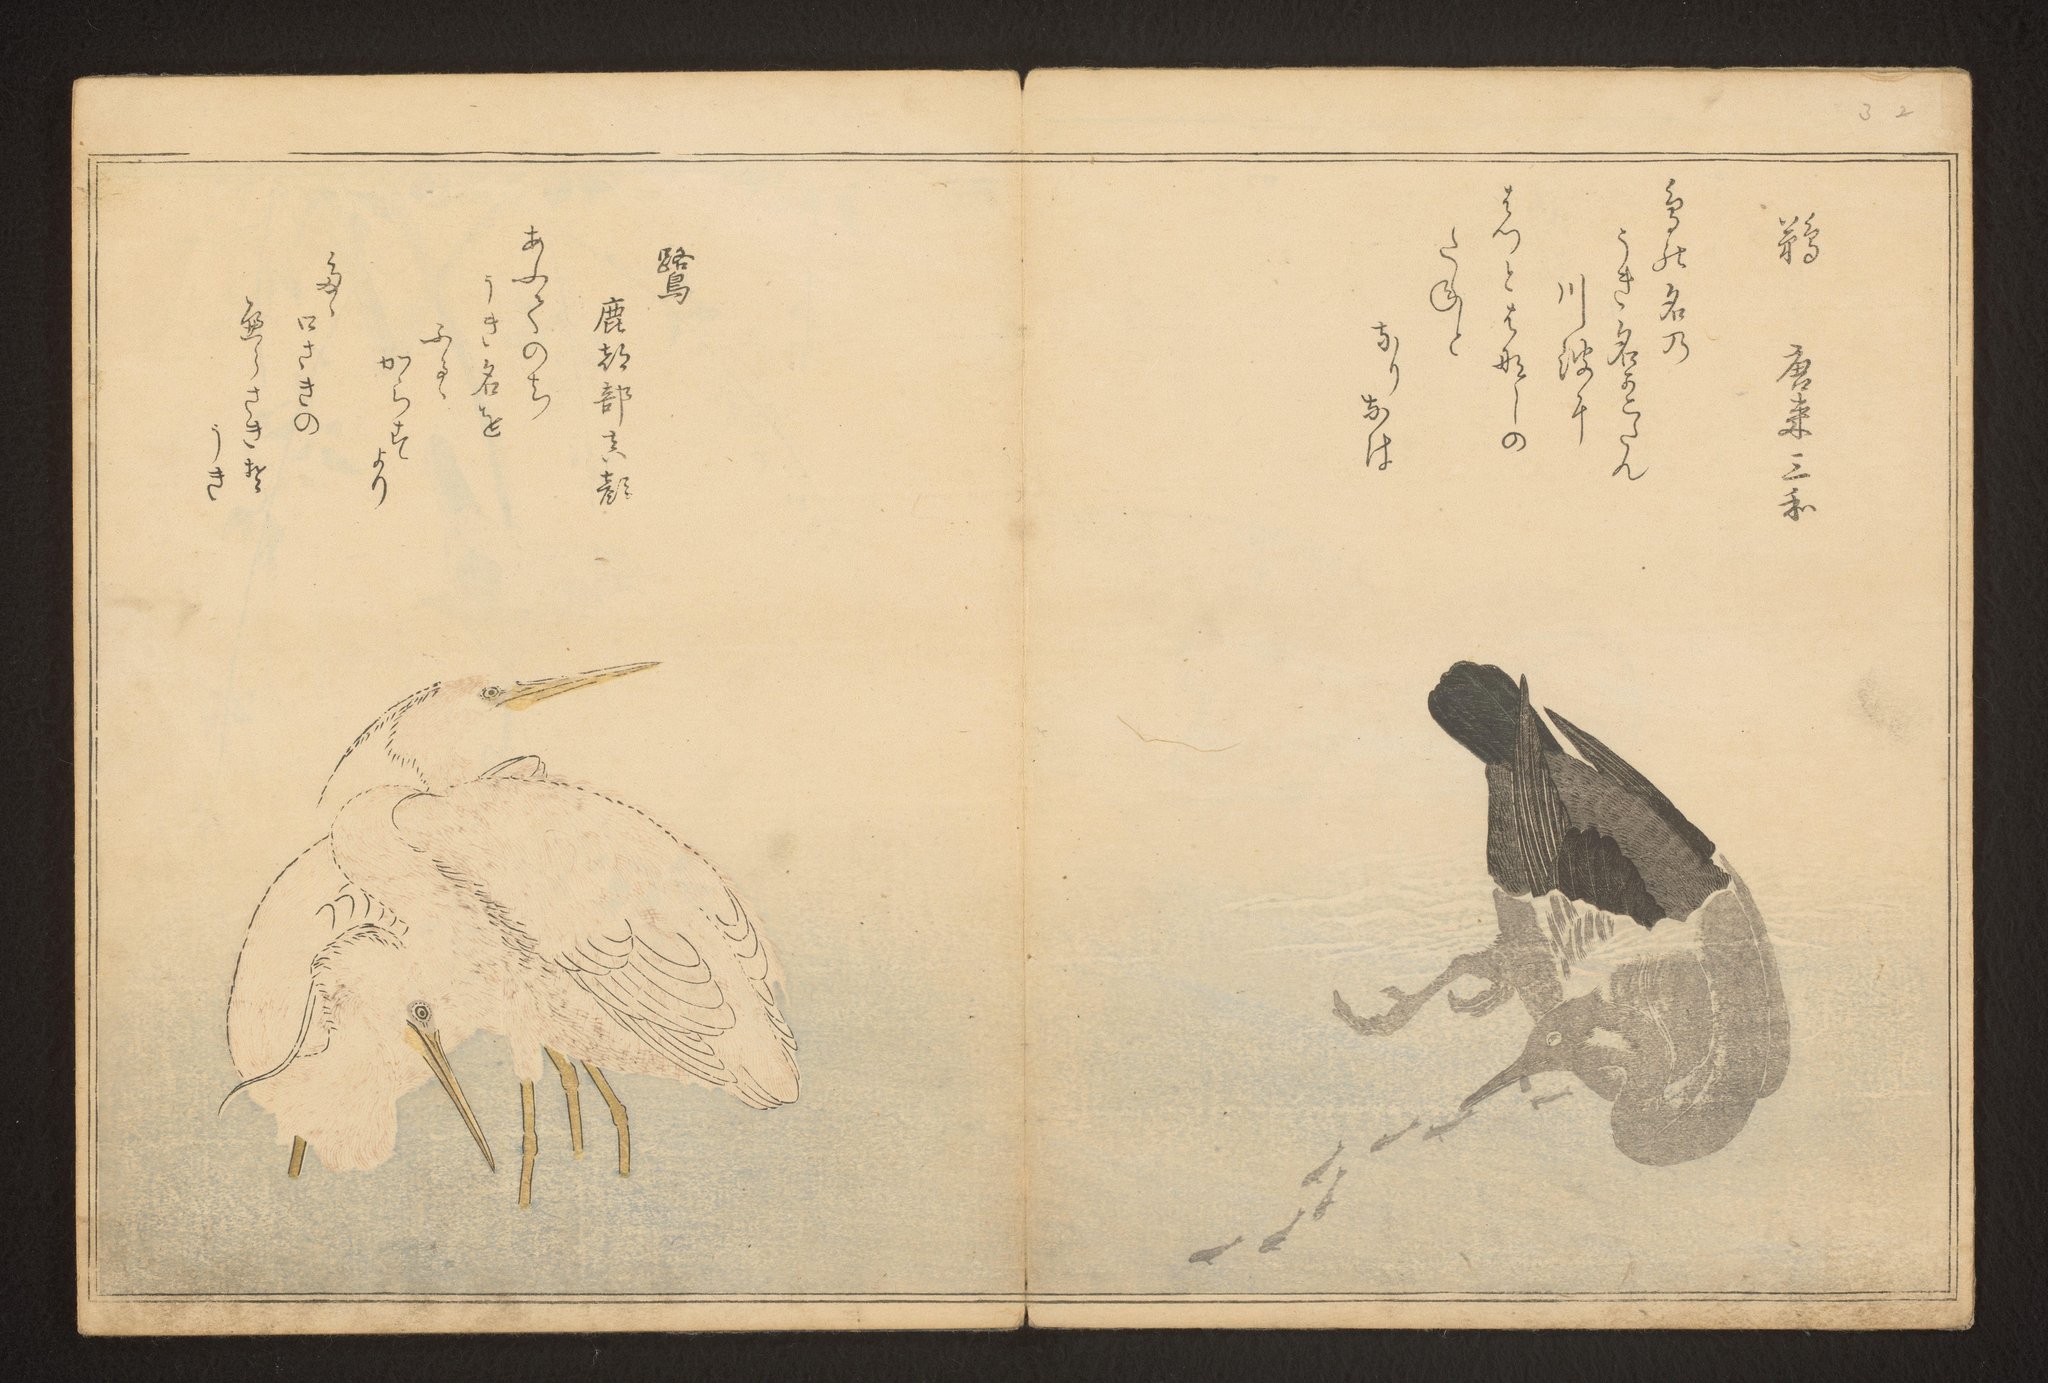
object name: page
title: Cormorant and heron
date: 1796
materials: paper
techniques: blind stamped, woodcut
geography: edo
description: Vijfde en zesde pagina van het vogelboek van Utamaro.